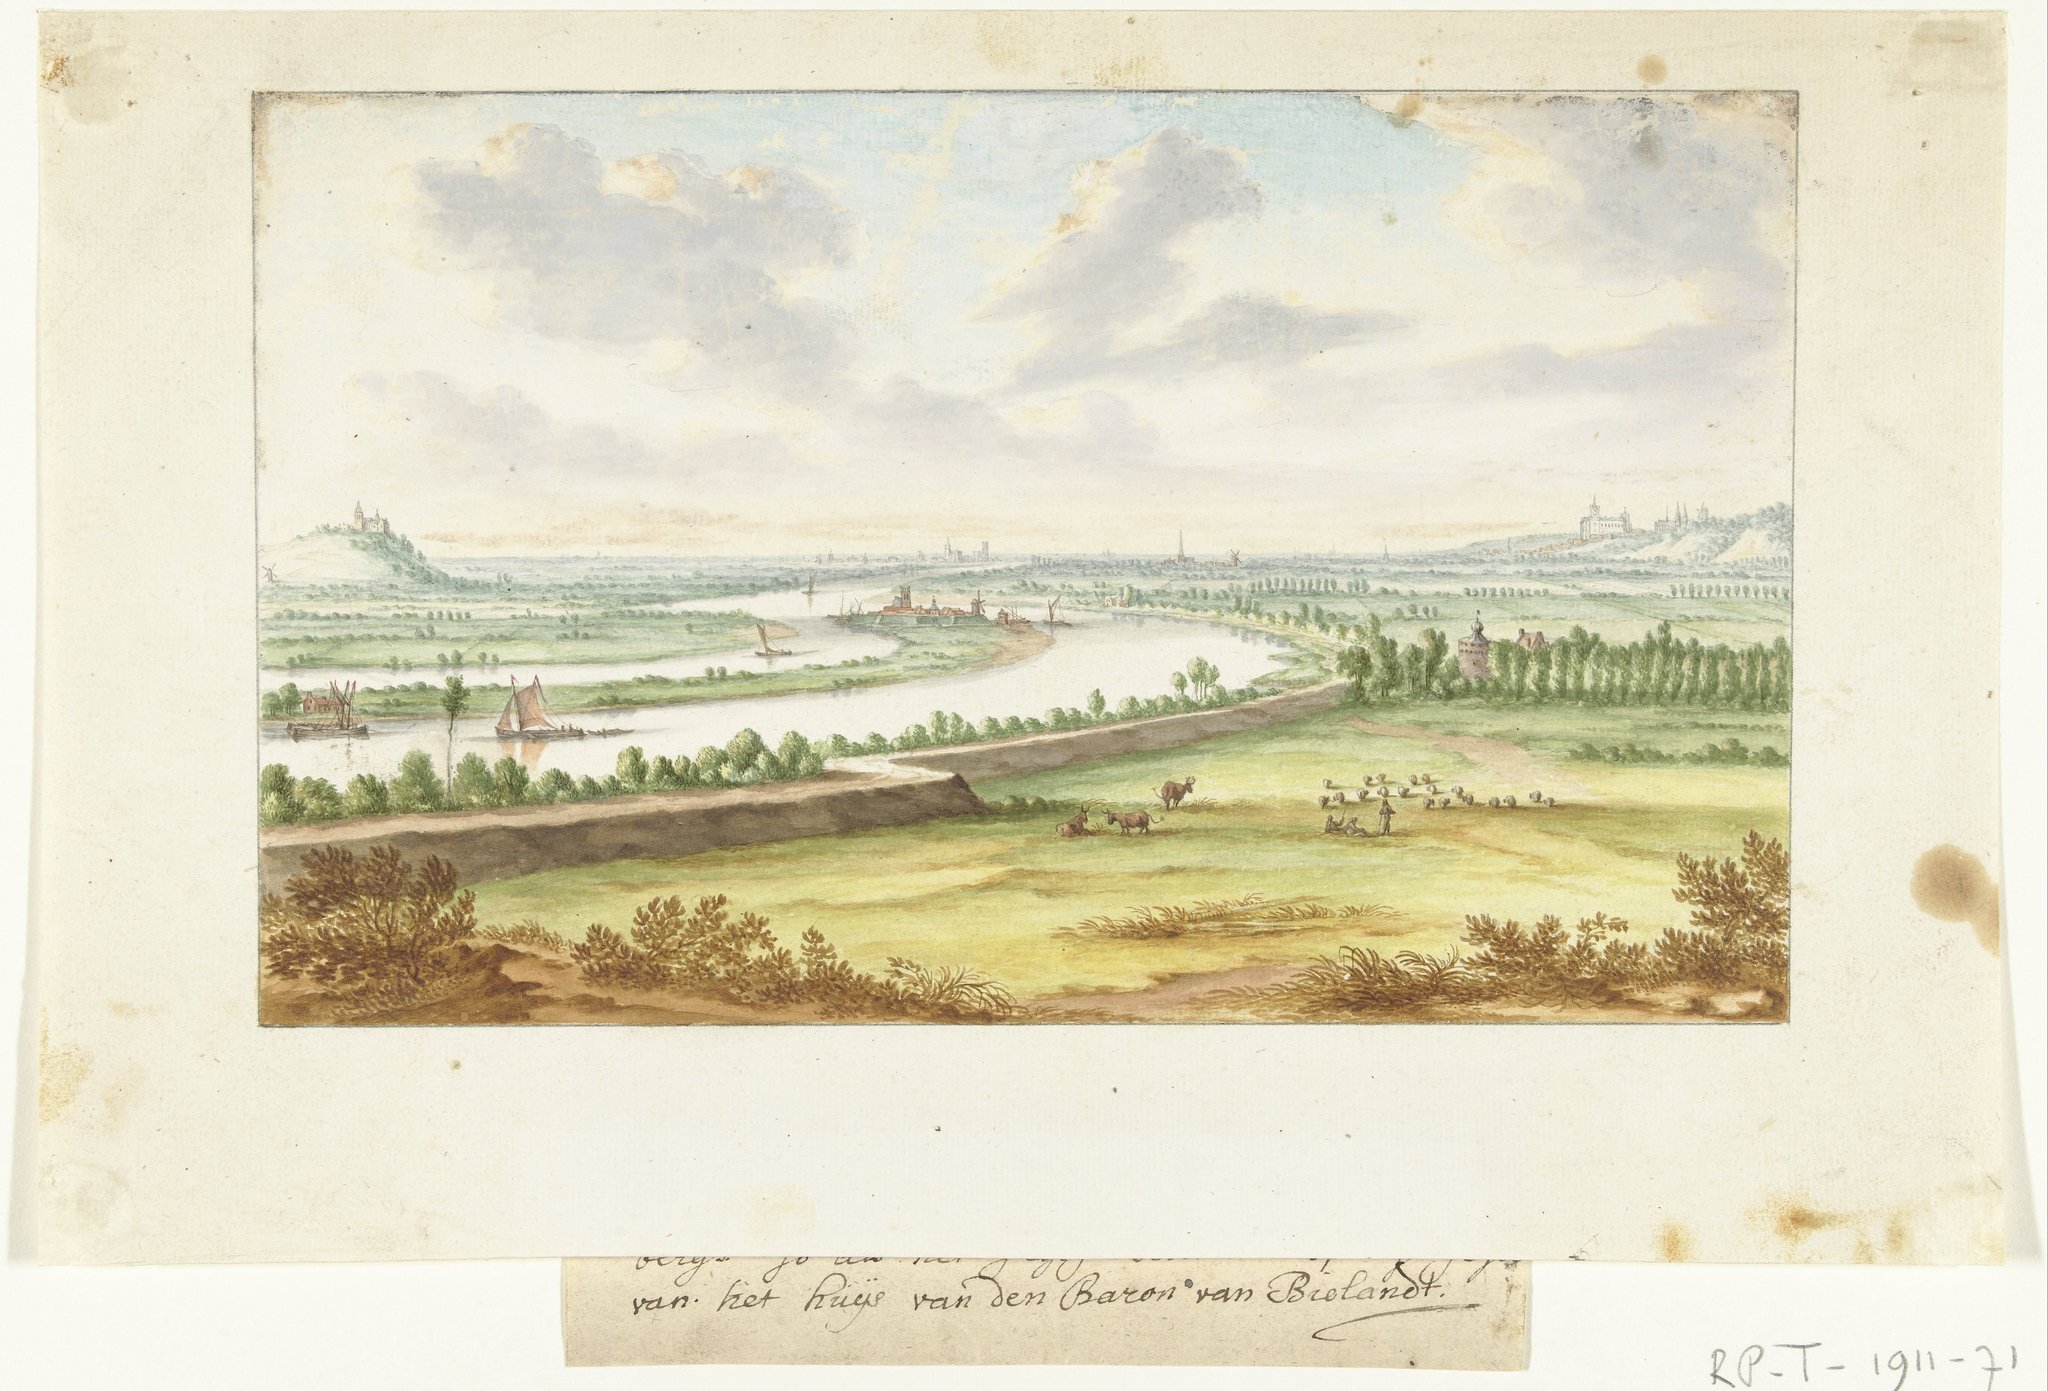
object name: drawing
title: Gezicht van Schenkenschans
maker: jan van call (i)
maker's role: draughtsman, print maker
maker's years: 1656-1706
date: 1666-1706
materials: chalk, paper, watercolor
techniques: brush